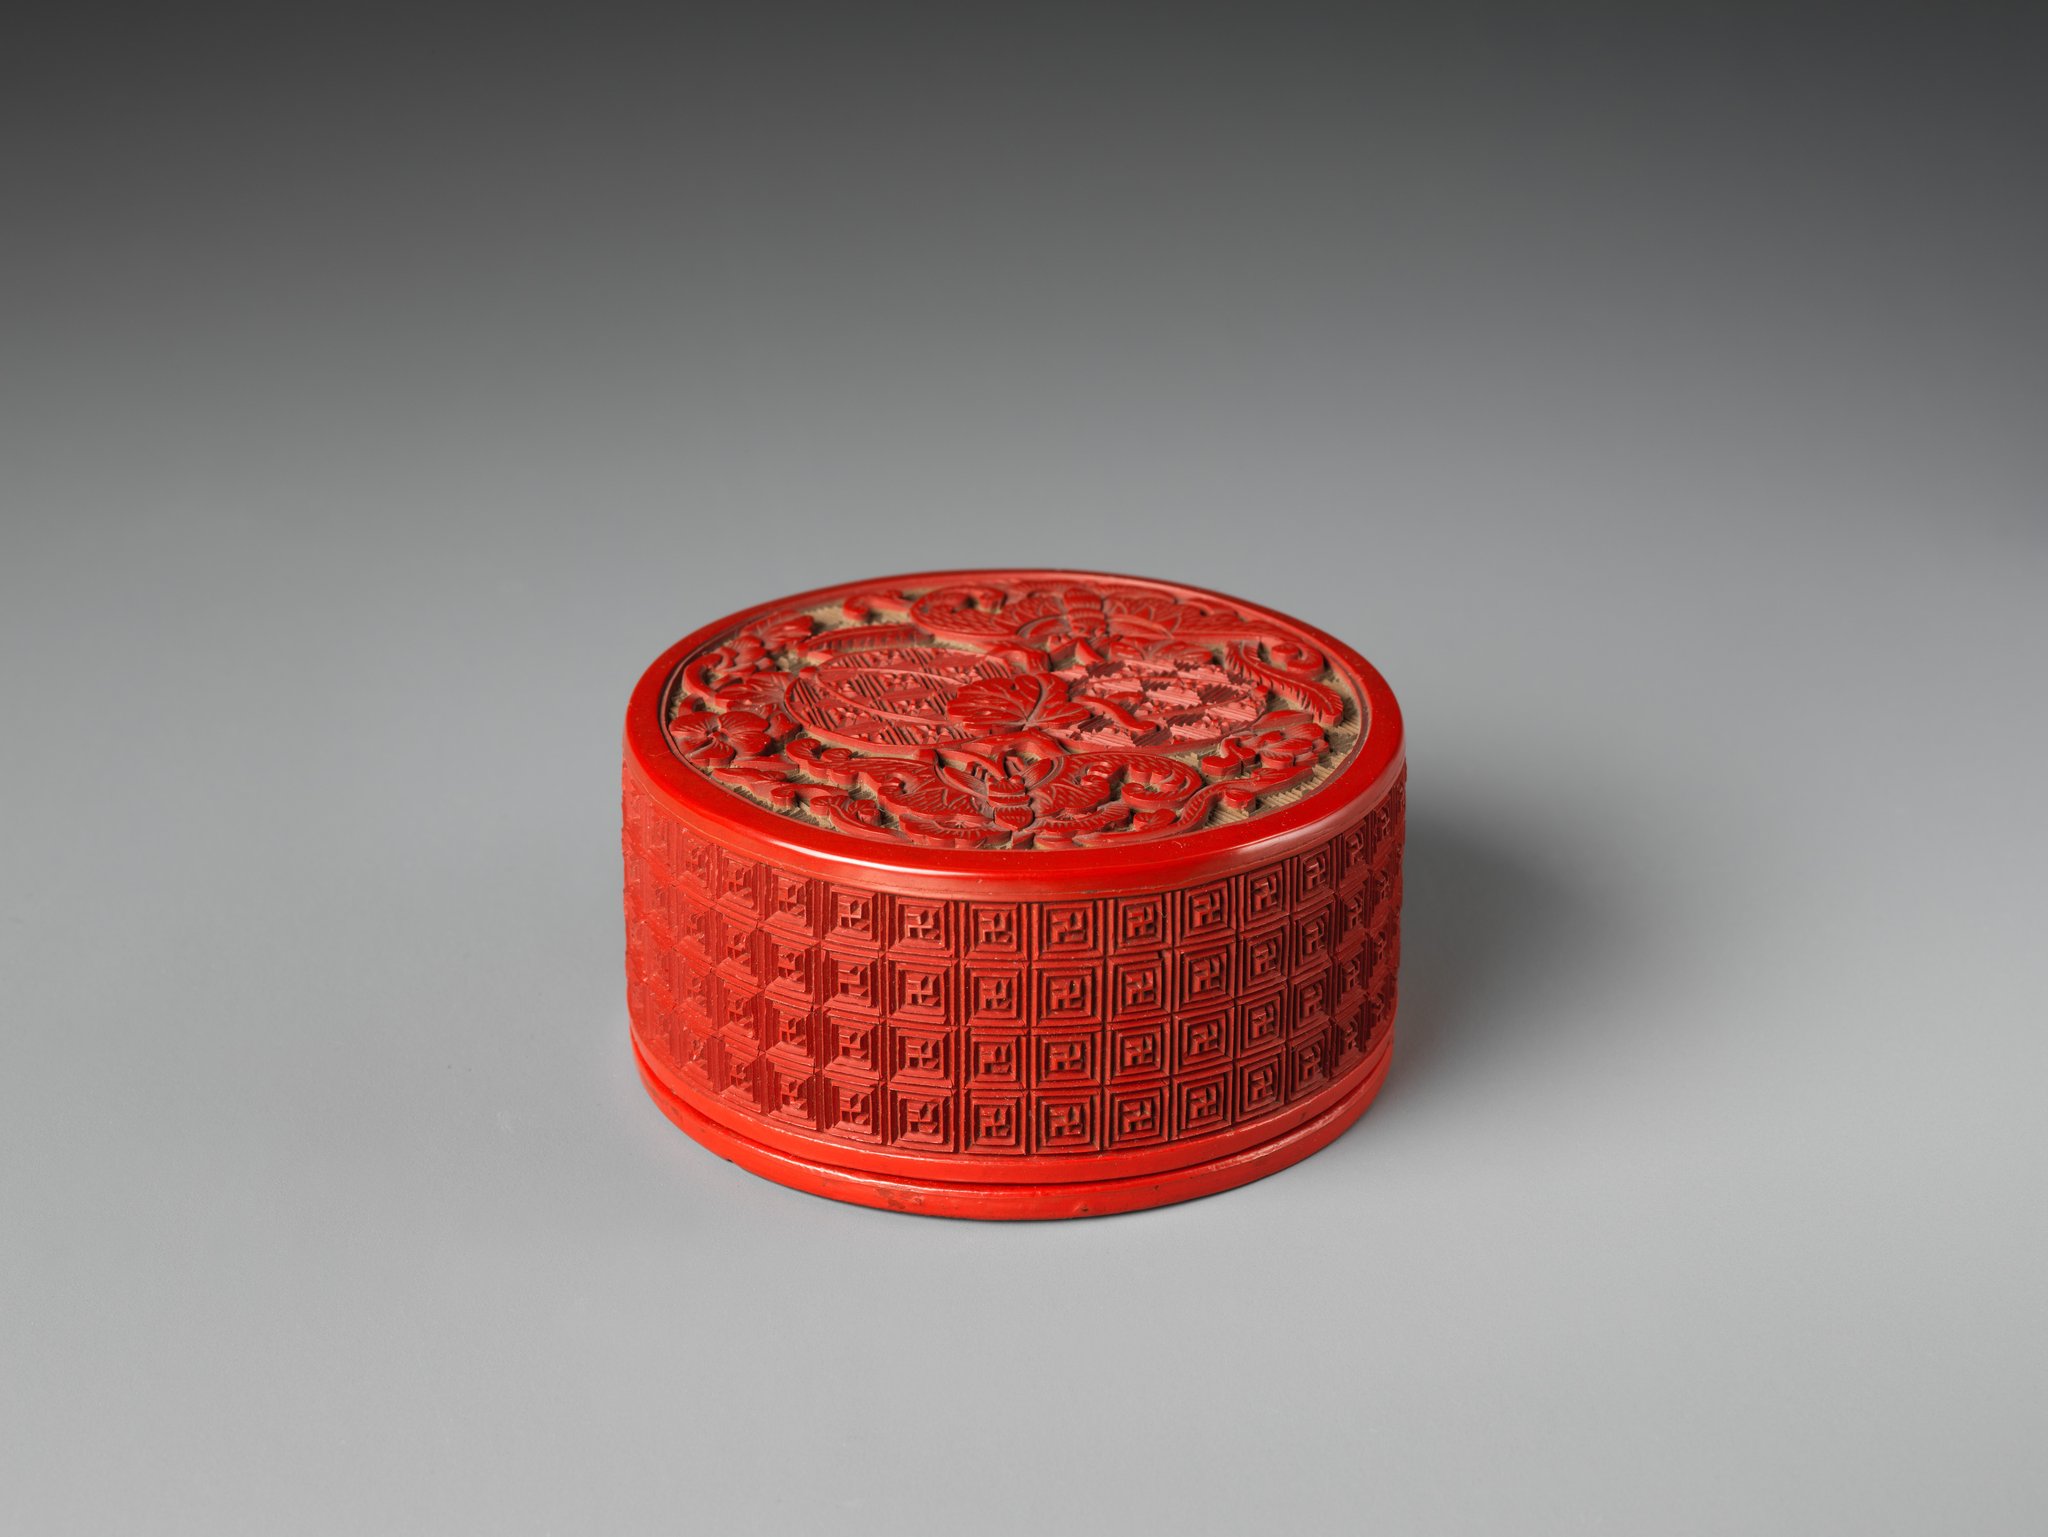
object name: pair of box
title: Pair of boxes with melons and butterflies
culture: chinese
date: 1801-1900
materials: lacquer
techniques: carving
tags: butterflies